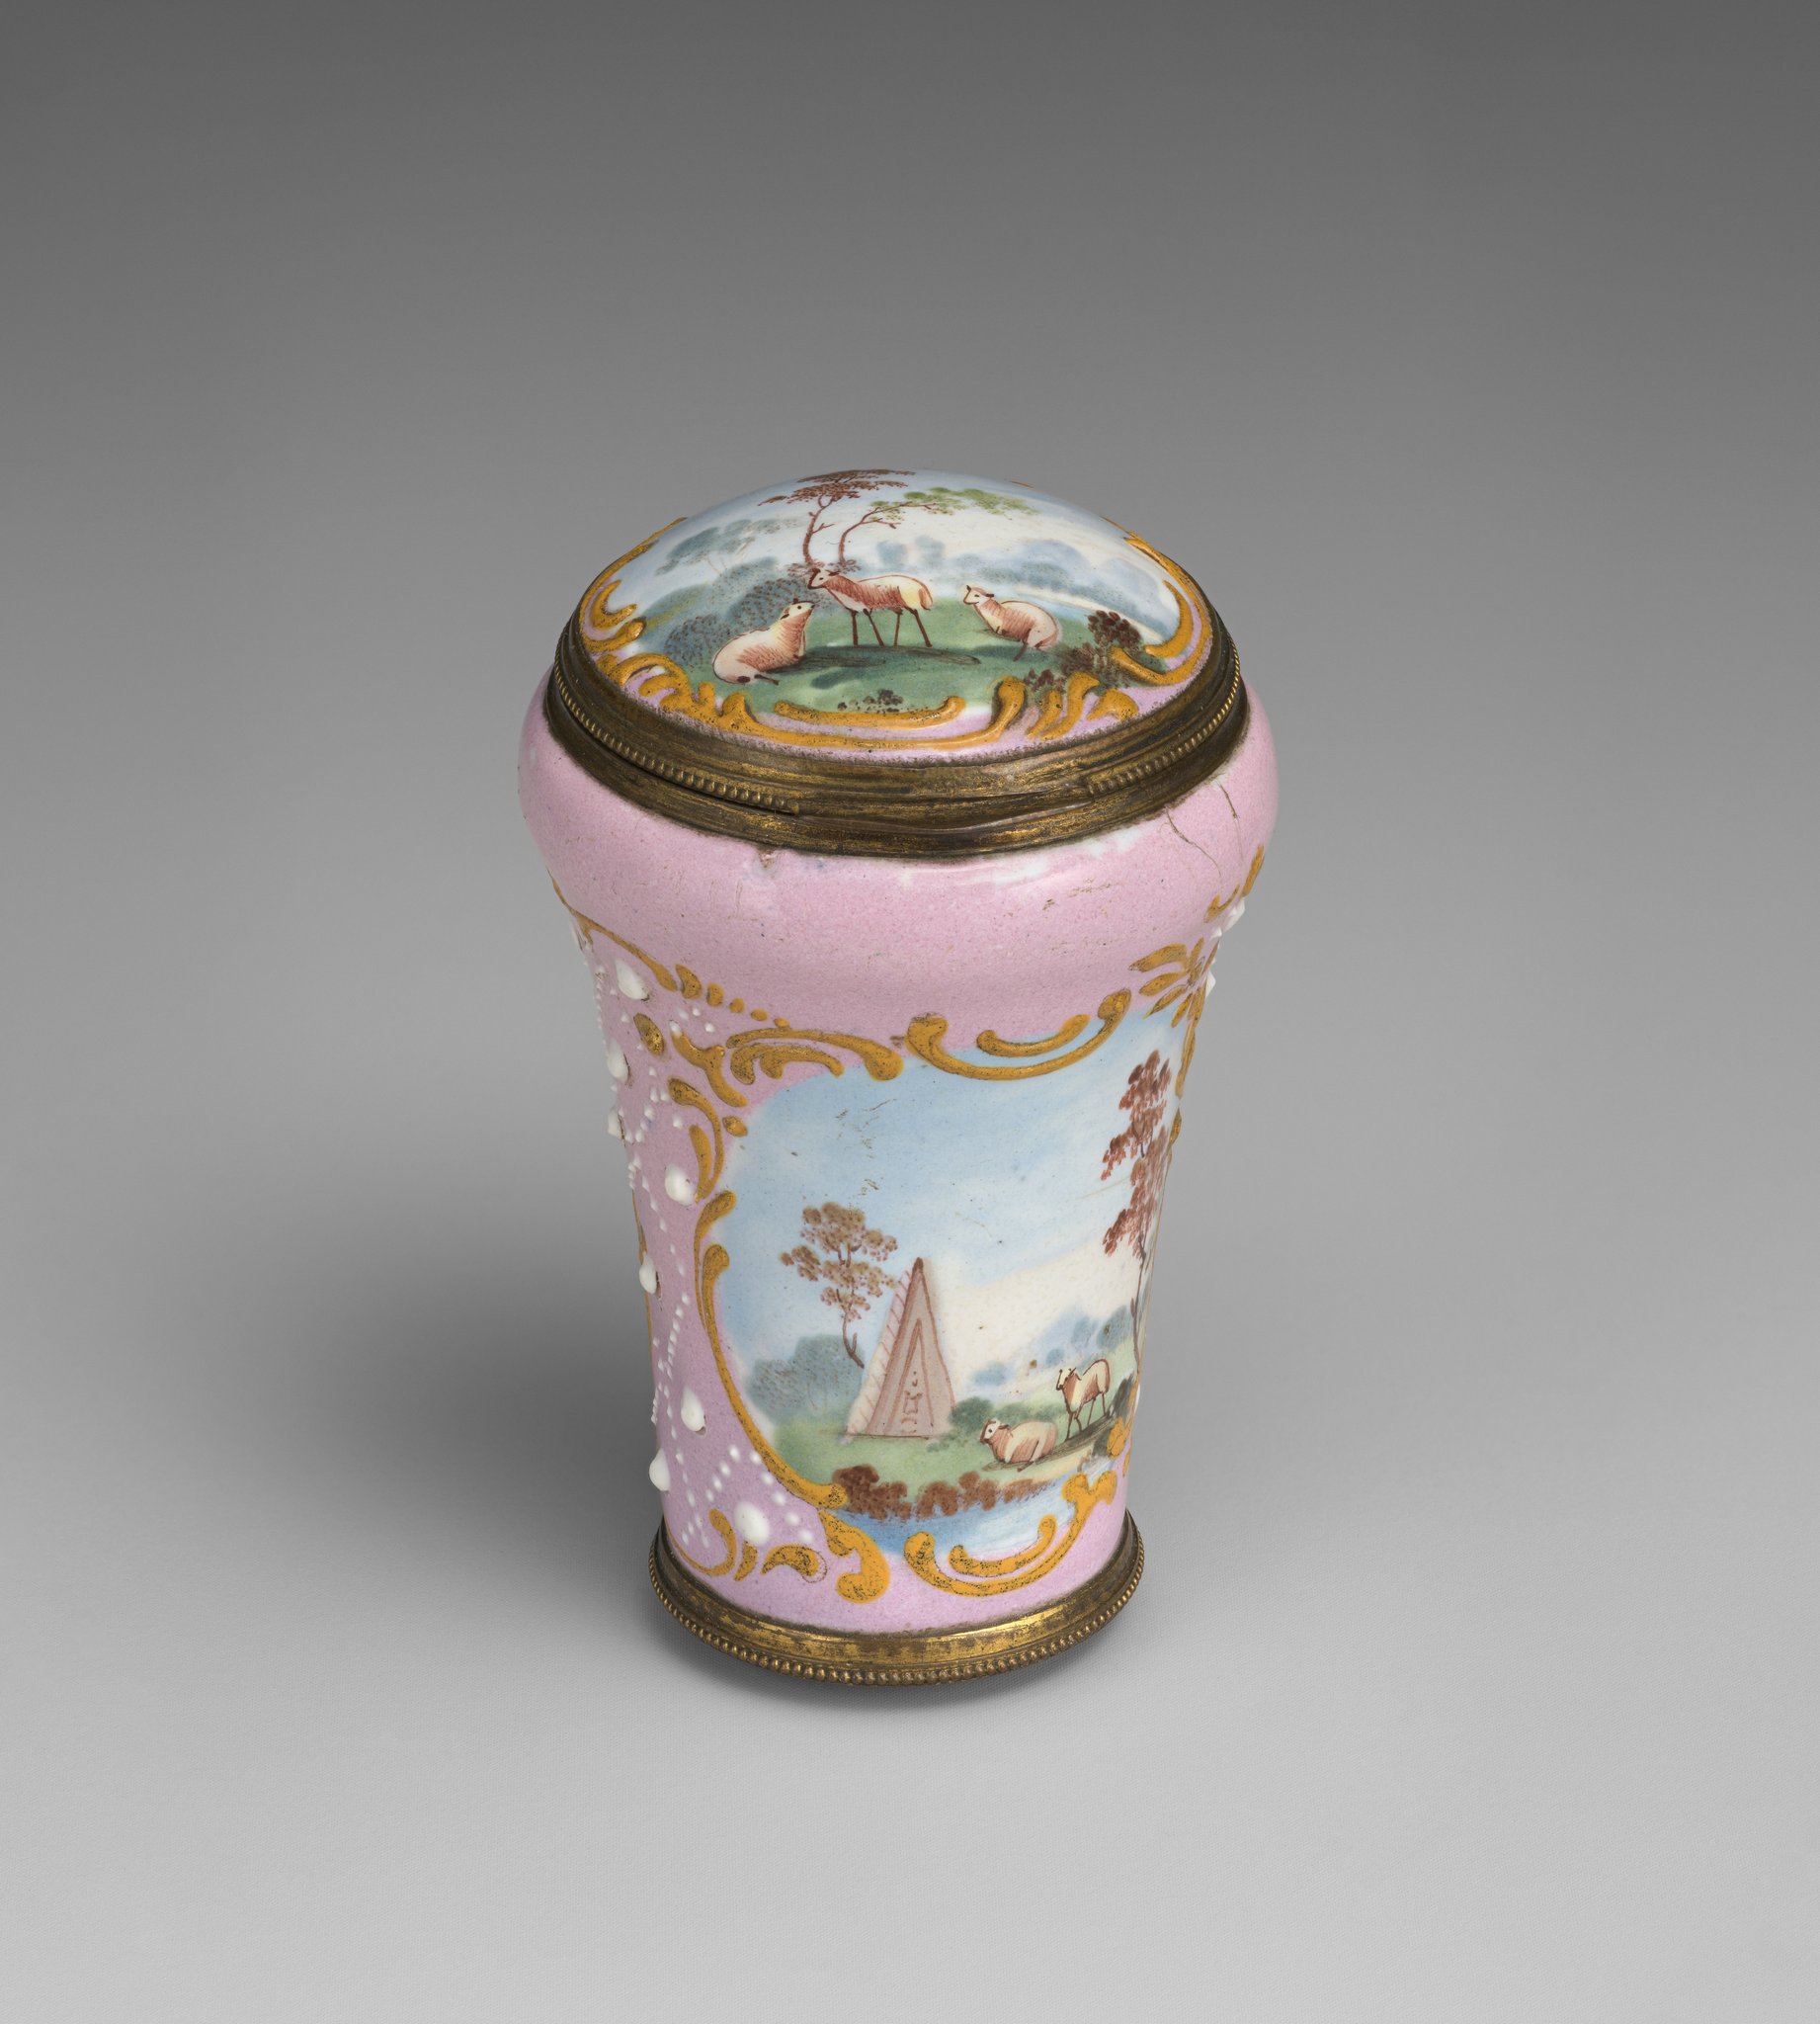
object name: bonbonnière cane handle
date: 1770-1780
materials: copper, enamel